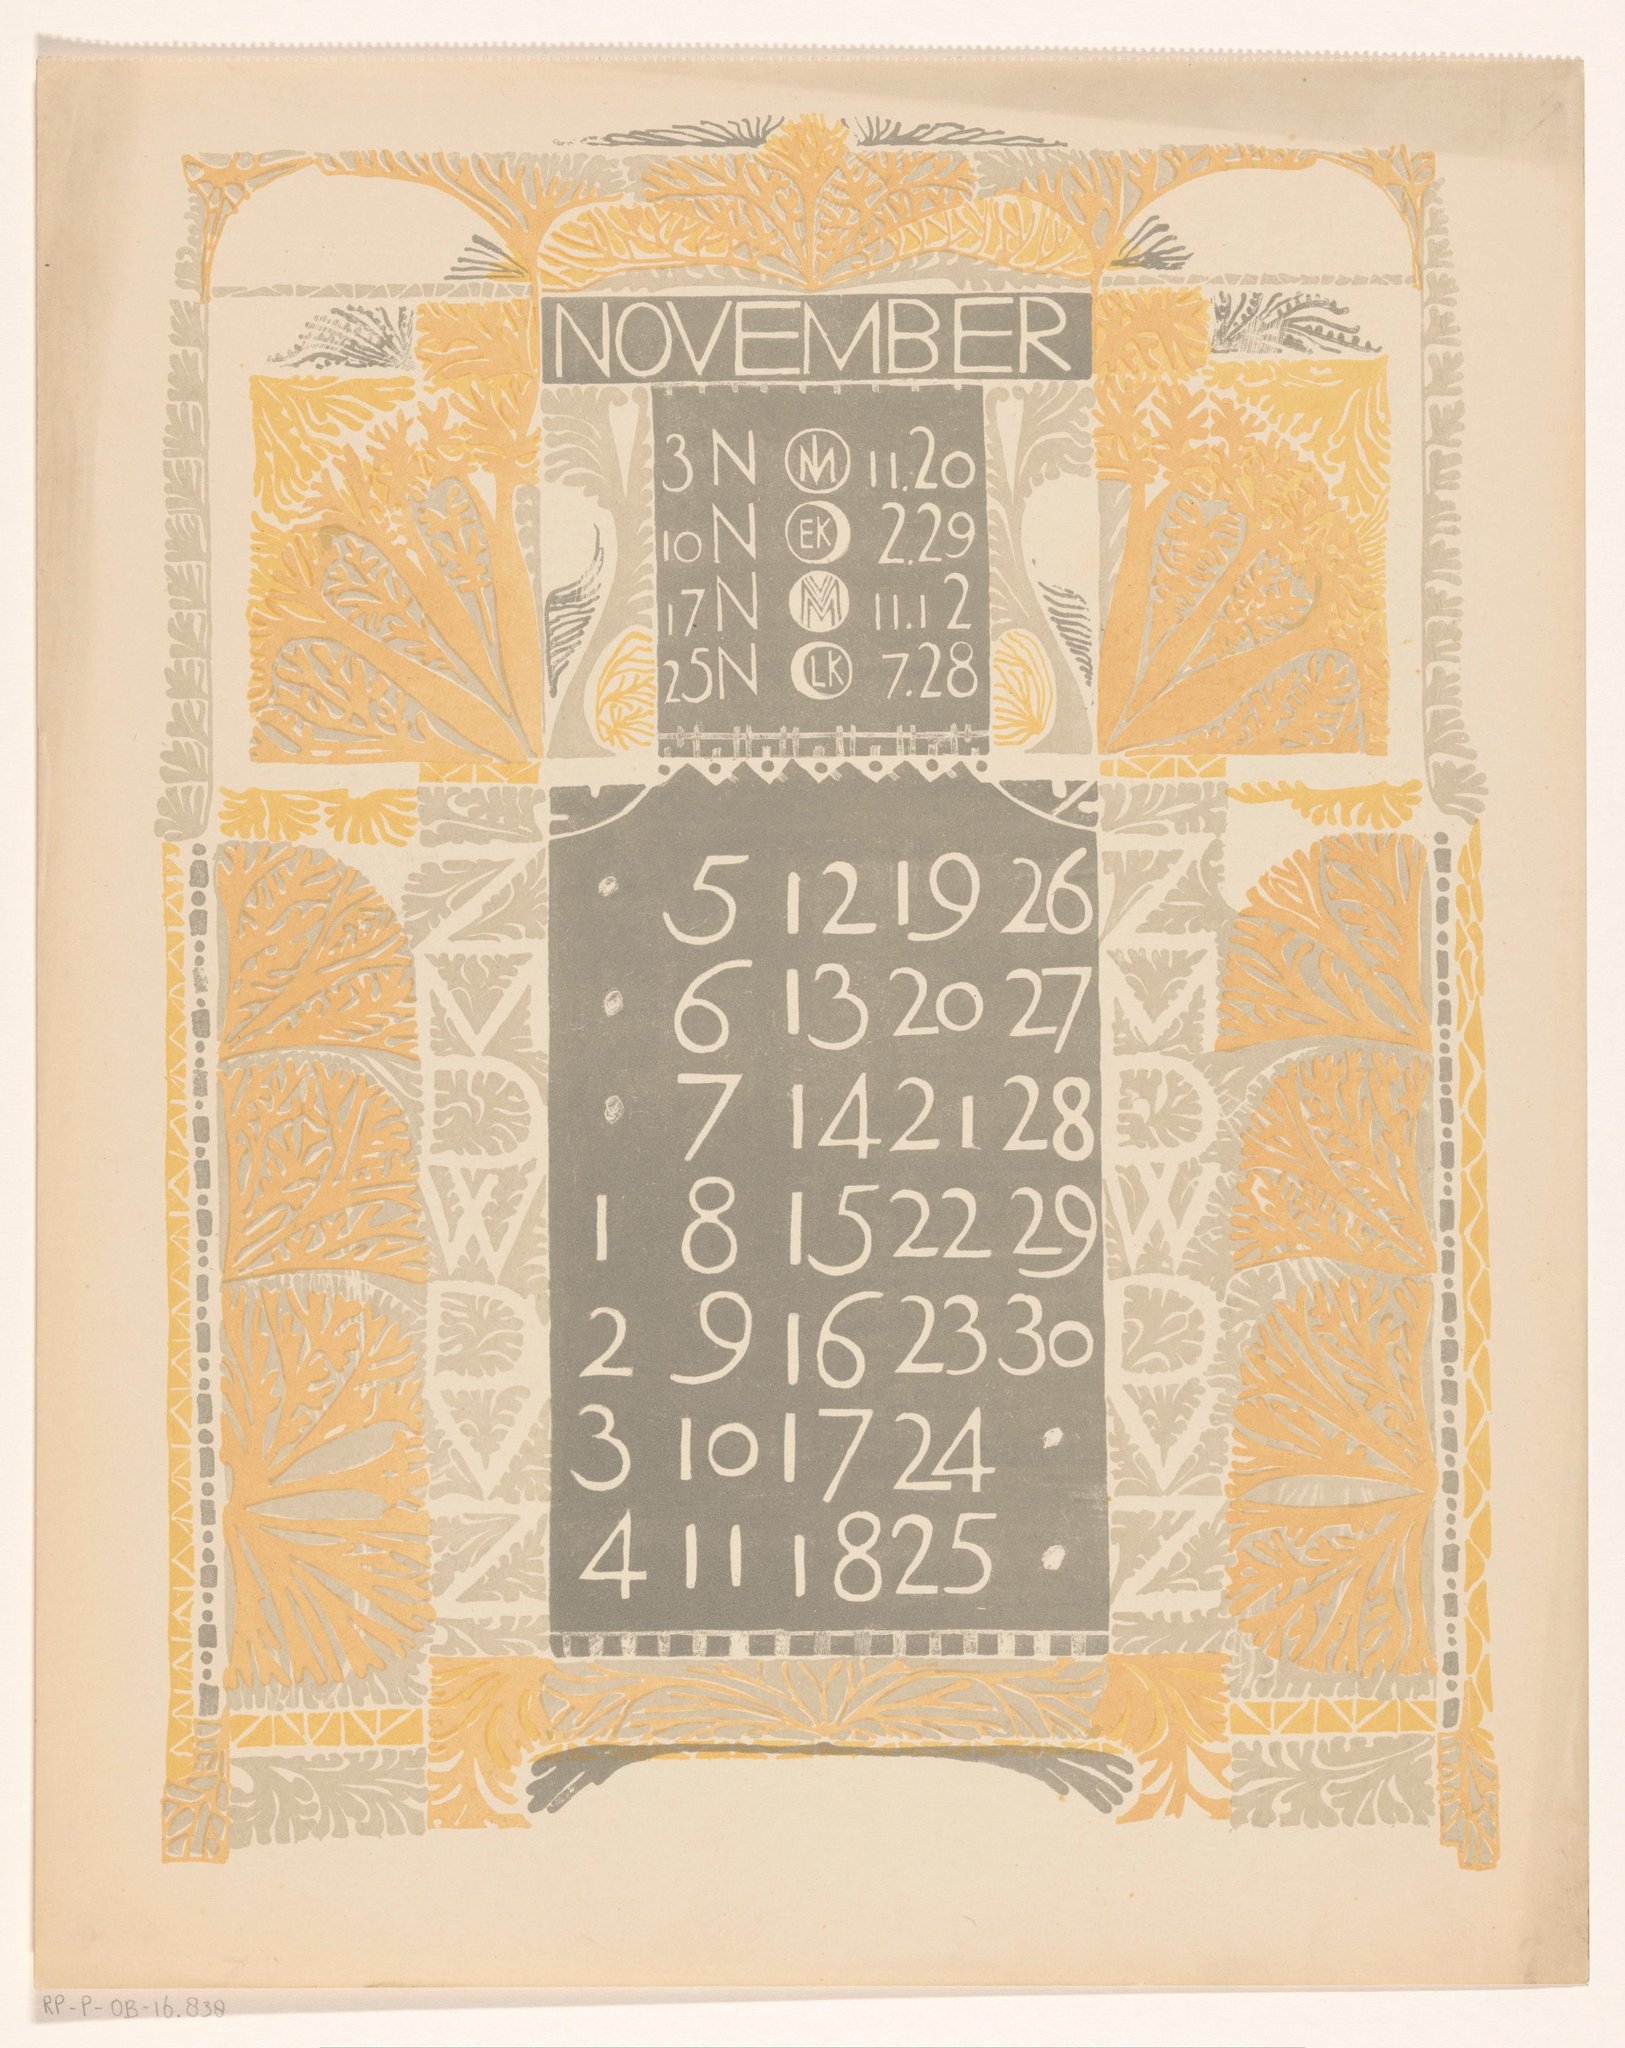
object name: print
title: Kalenderblad november 1899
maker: carel adolph lion cachet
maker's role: draughtsman, print maker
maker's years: 1864-1945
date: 1899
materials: paper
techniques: lithograph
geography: amsterdam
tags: foliage, tendrils, branches ~ ornament, november ~ other concepts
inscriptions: collector's mark: Lugt 2228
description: In 1898 vervaardigden Gerrit Willem Dijsselhof, Carel Adolph Lion Cachet en Theo Nieuwenhuis samen een kalender voor het jaar 1899. Lion Cachet nam het ontwerp van de maanden februari, mei, augustus en november op zich.